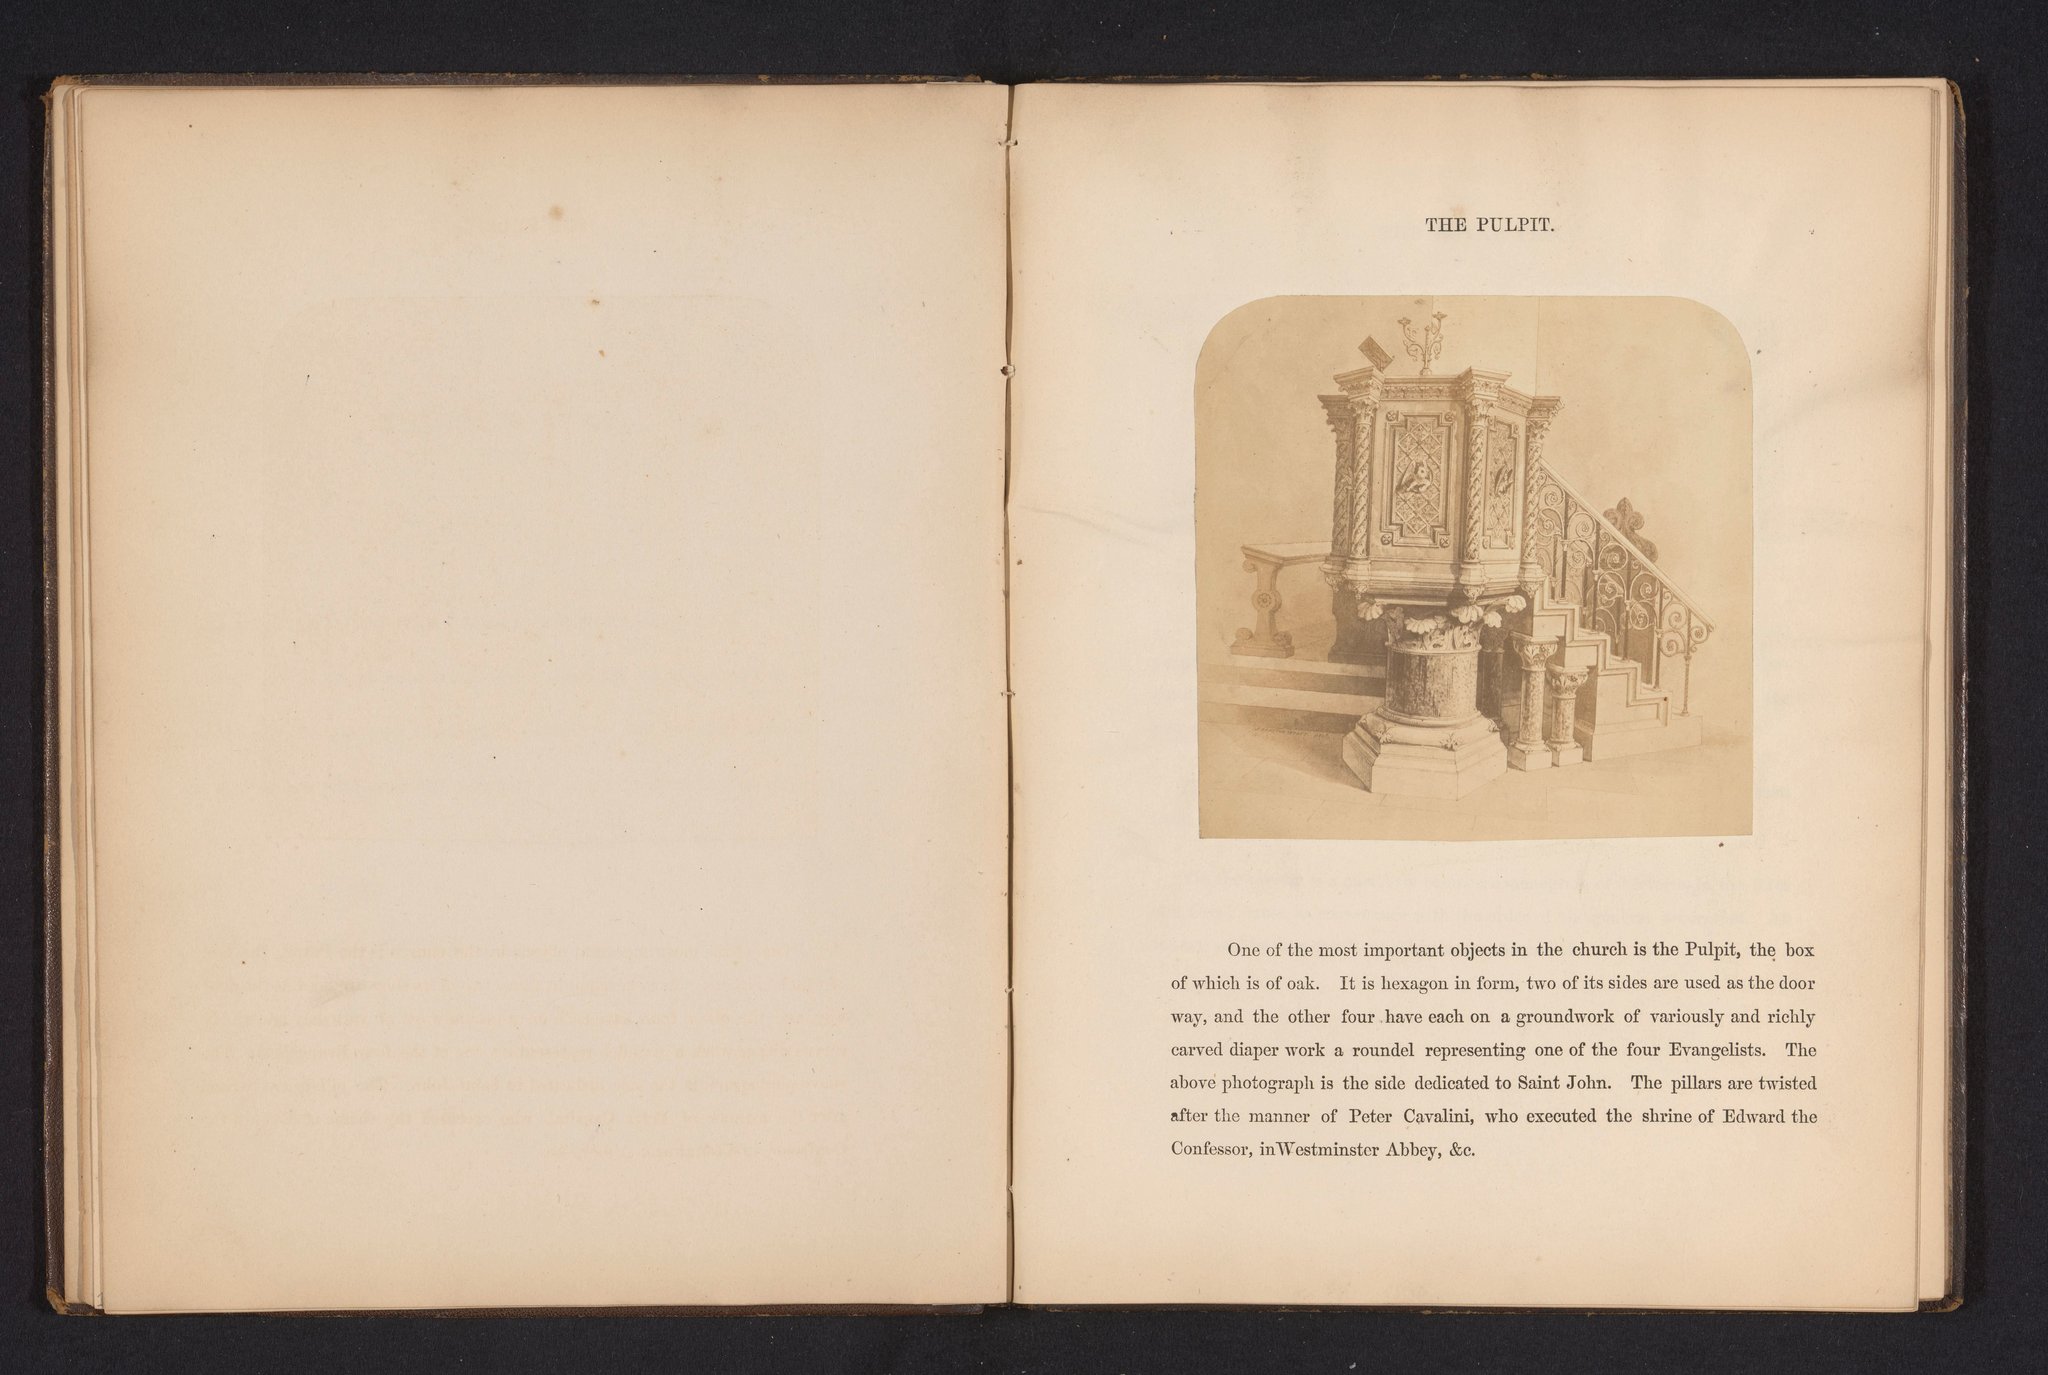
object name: photograph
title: The pulpit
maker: Anonymous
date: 1857-1867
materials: photographic support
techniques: albumen print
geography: st michael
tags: pulpit, ambo, chancel